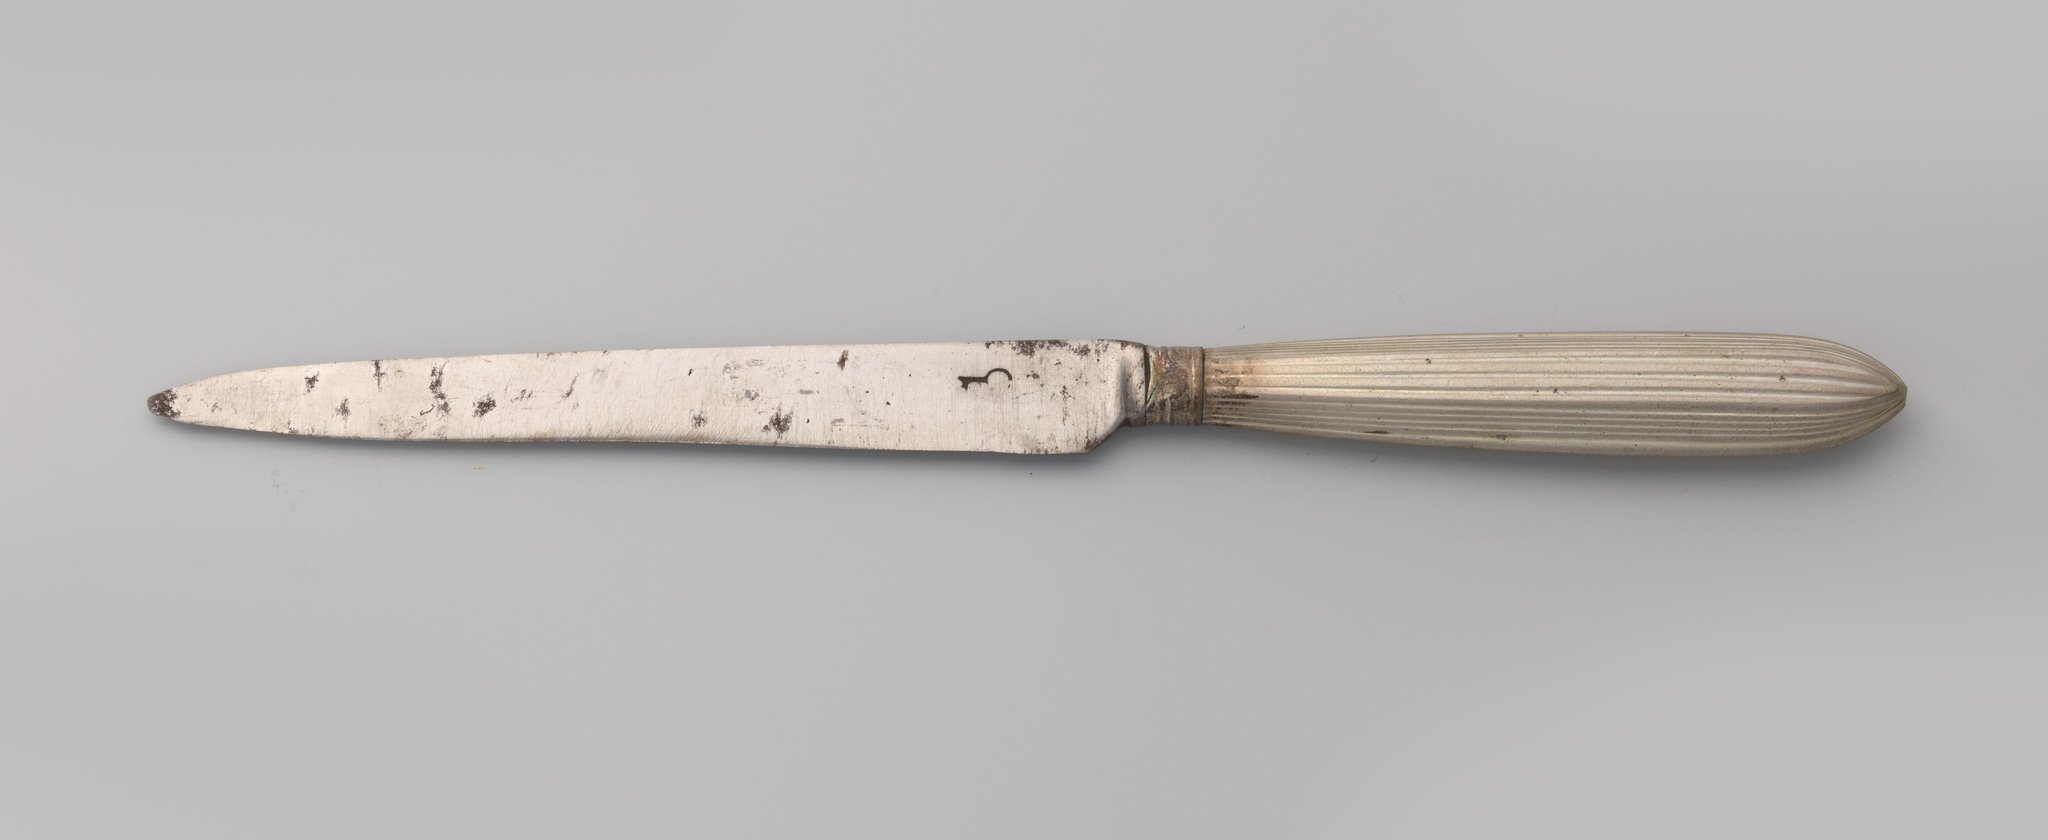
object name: knife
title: Mes met spits toelopend overlangs gegroefd heft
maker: Anonymous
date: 1800-1900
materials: silver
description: Mes van zilver met overlangs gegroefd spits toelopend heft.